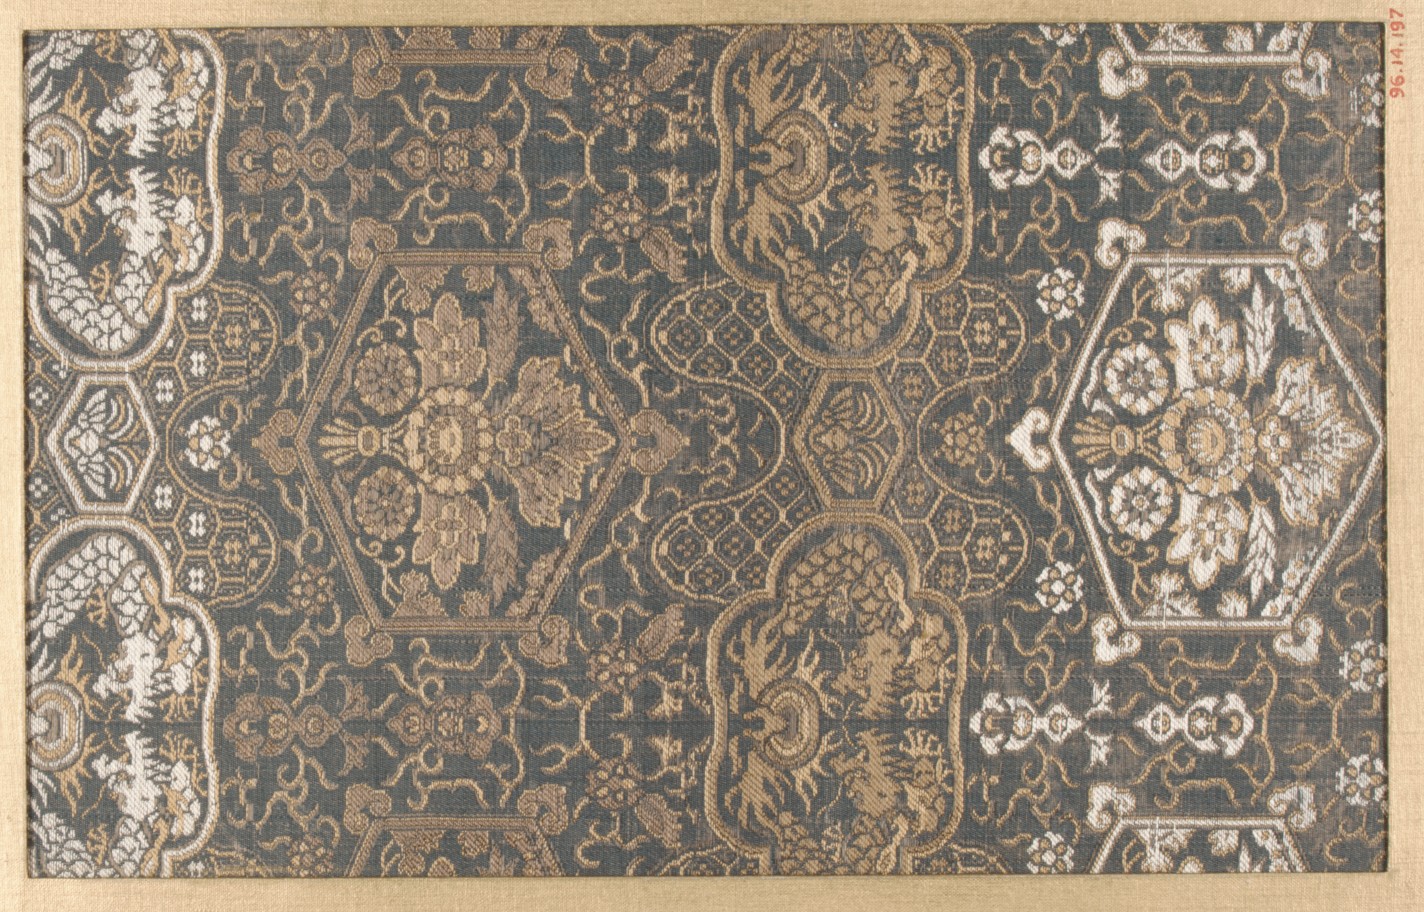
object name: piece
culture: japanese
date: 1701-1900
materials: silk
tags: flowers